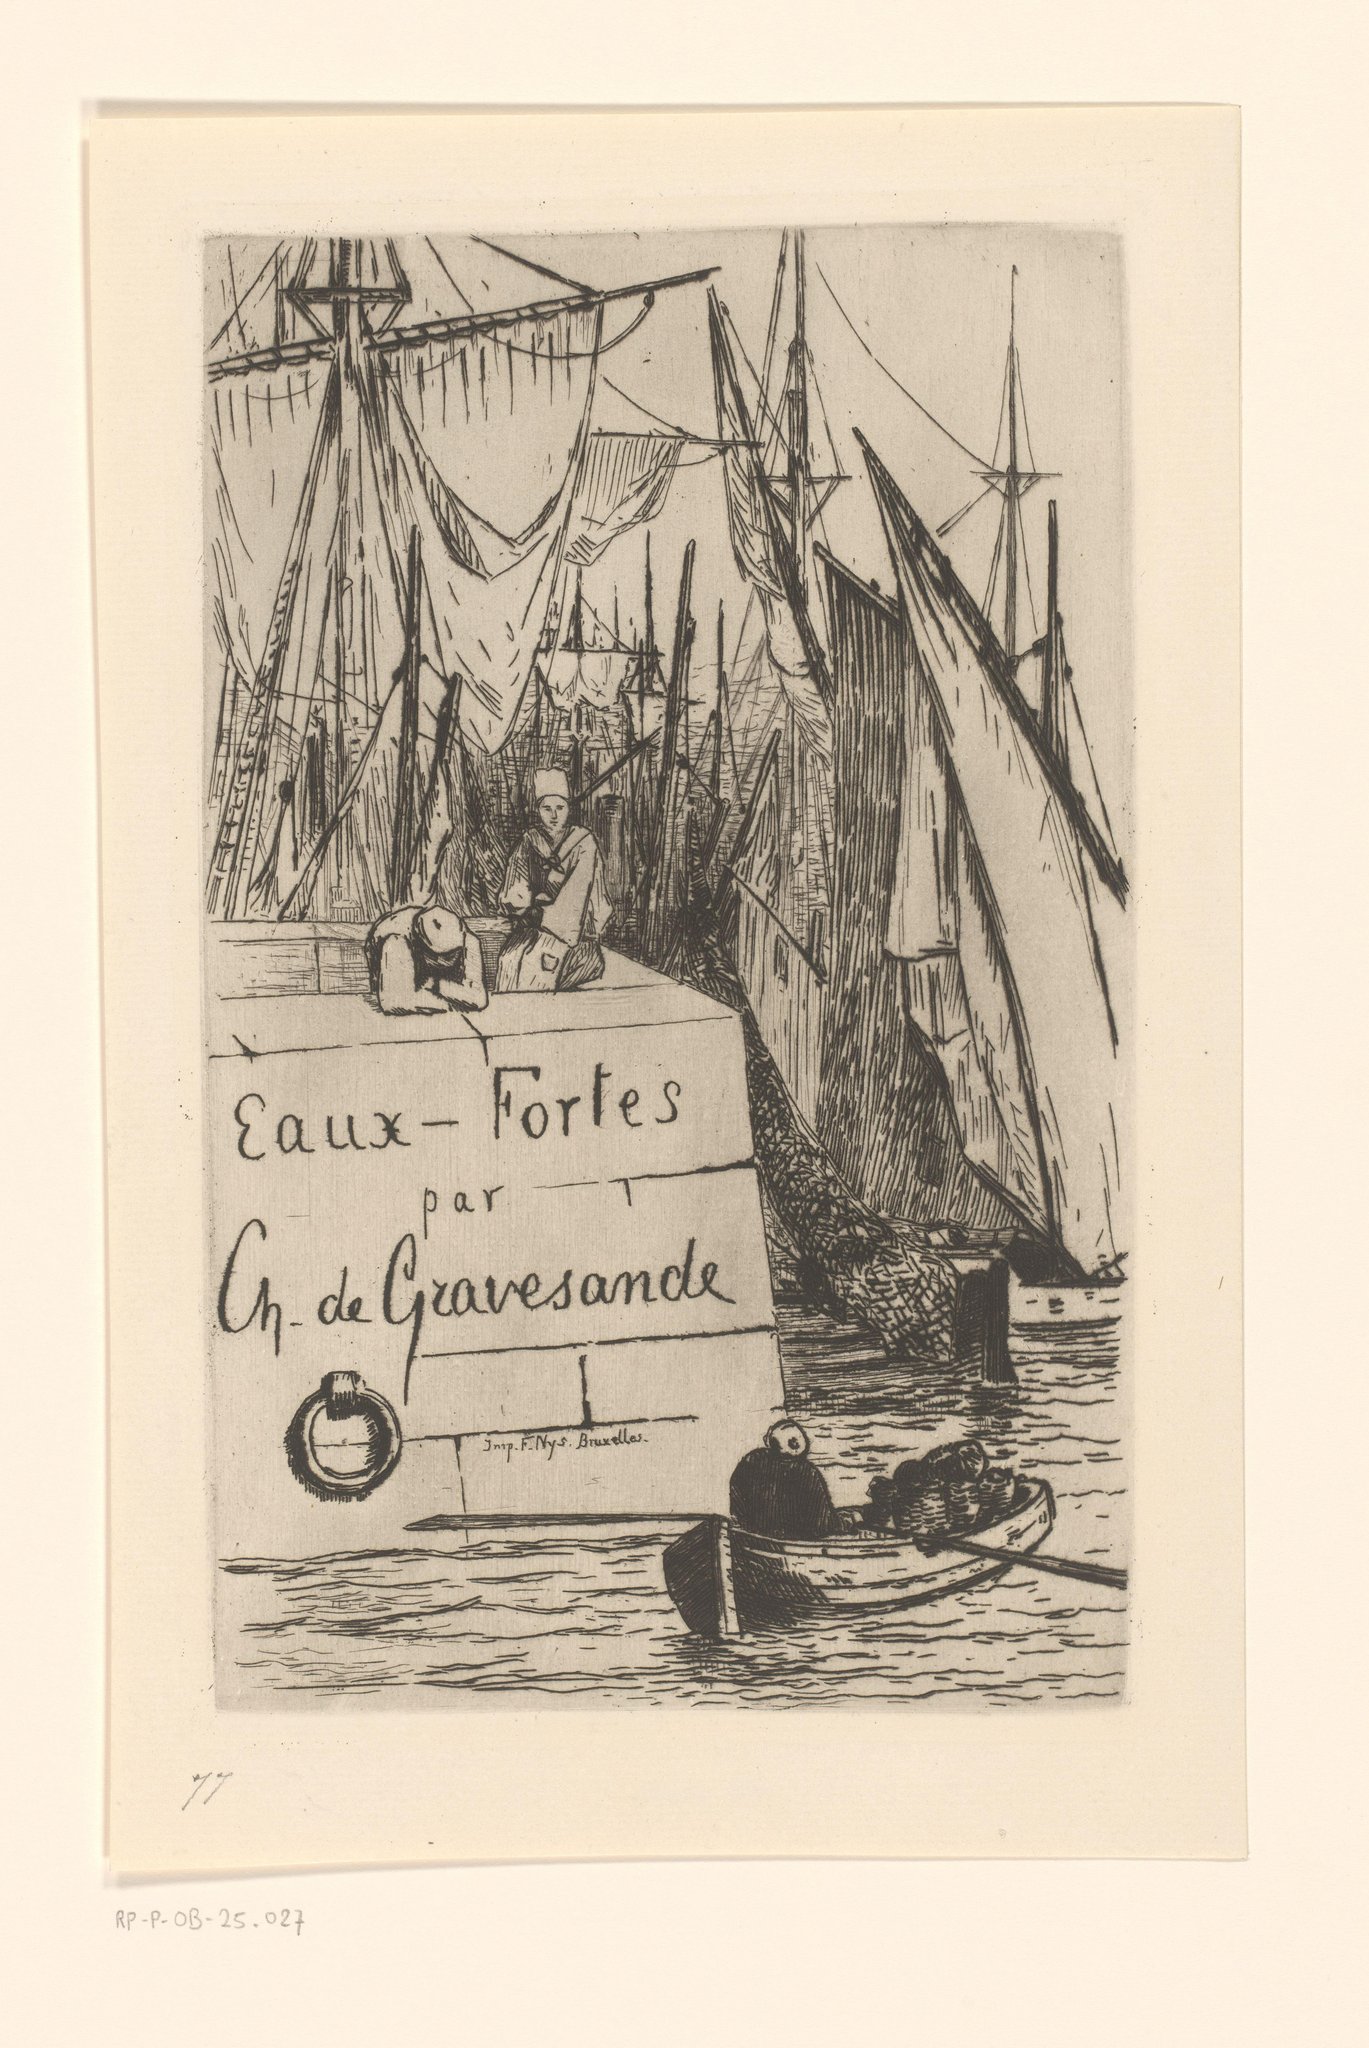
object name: print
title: Souvenir du Hâvre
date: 1873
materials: paper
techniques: etching, intaglio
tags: harbour, le havre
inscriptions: collector's mark: Lugt 2228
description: Vooraan zit iemand in een roeiboot; achteraan masten van schepen. Op de kade staat de tekst: 'Eaux-Fortes par Ch. de Gravesande'.